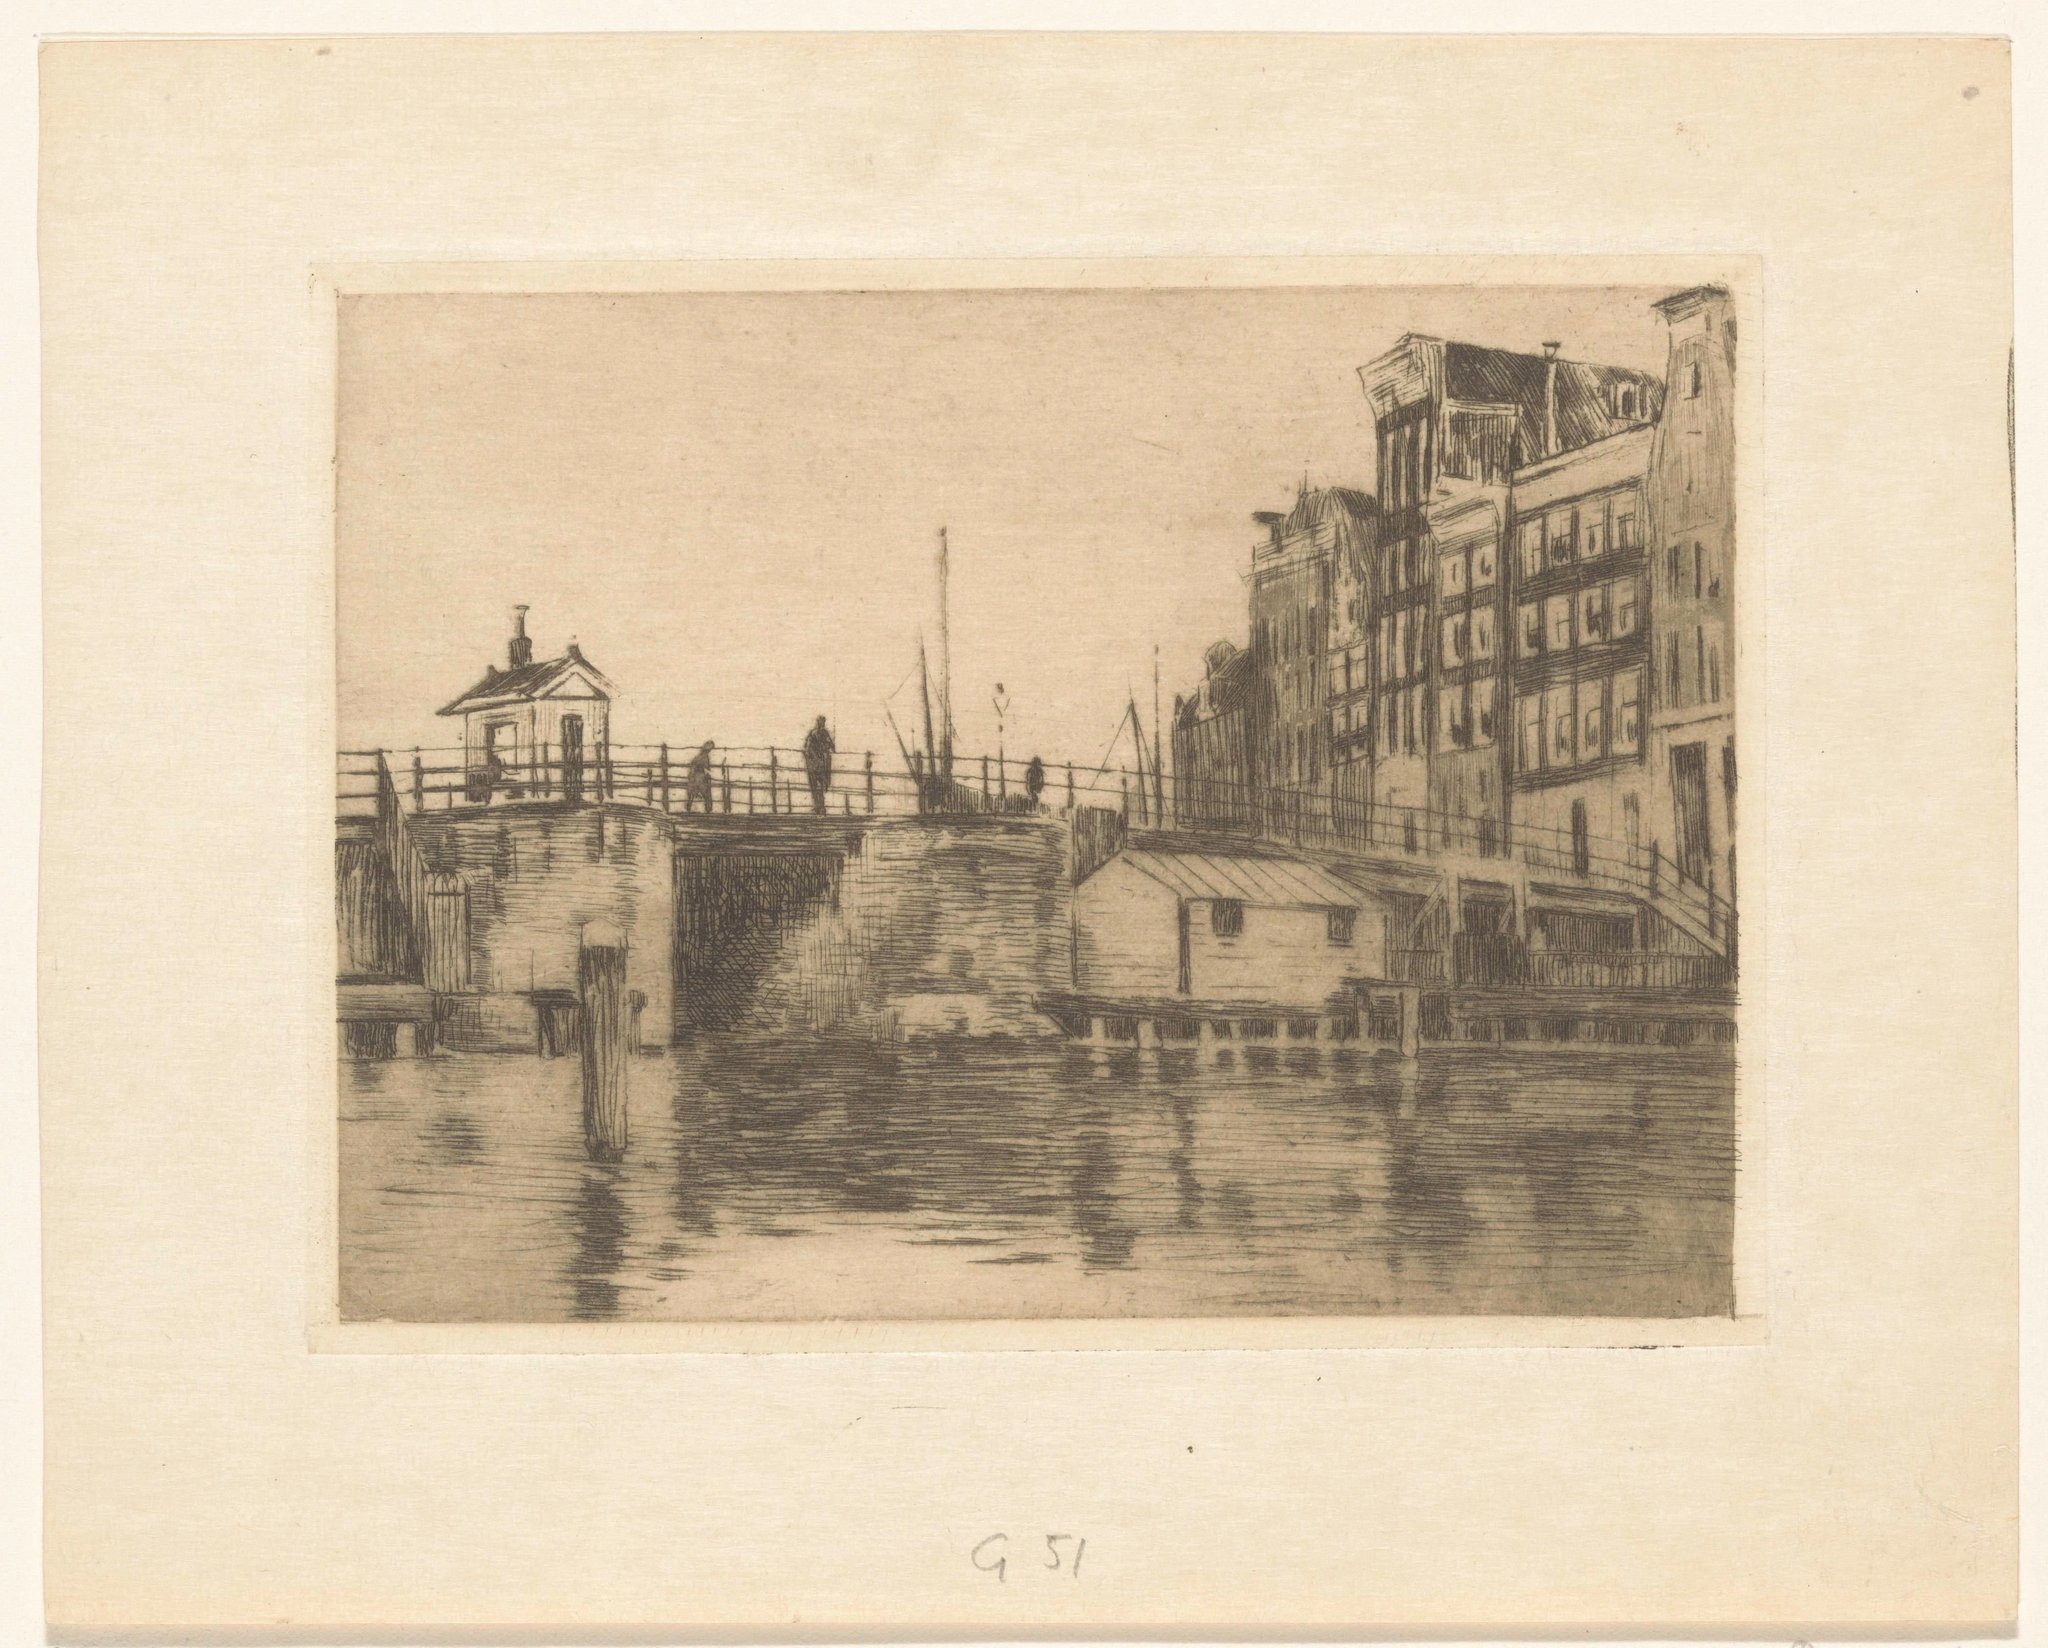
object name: print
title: Gezicht op de Kraansluis in Amsterdam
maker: willem witsen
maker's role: draughtsman, painter, print maker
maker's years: 1860-1923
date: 1911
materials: paper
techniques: etching, intaglio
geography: amsterdam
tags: canals, waters (in city), the usual house or row of houses, bridge